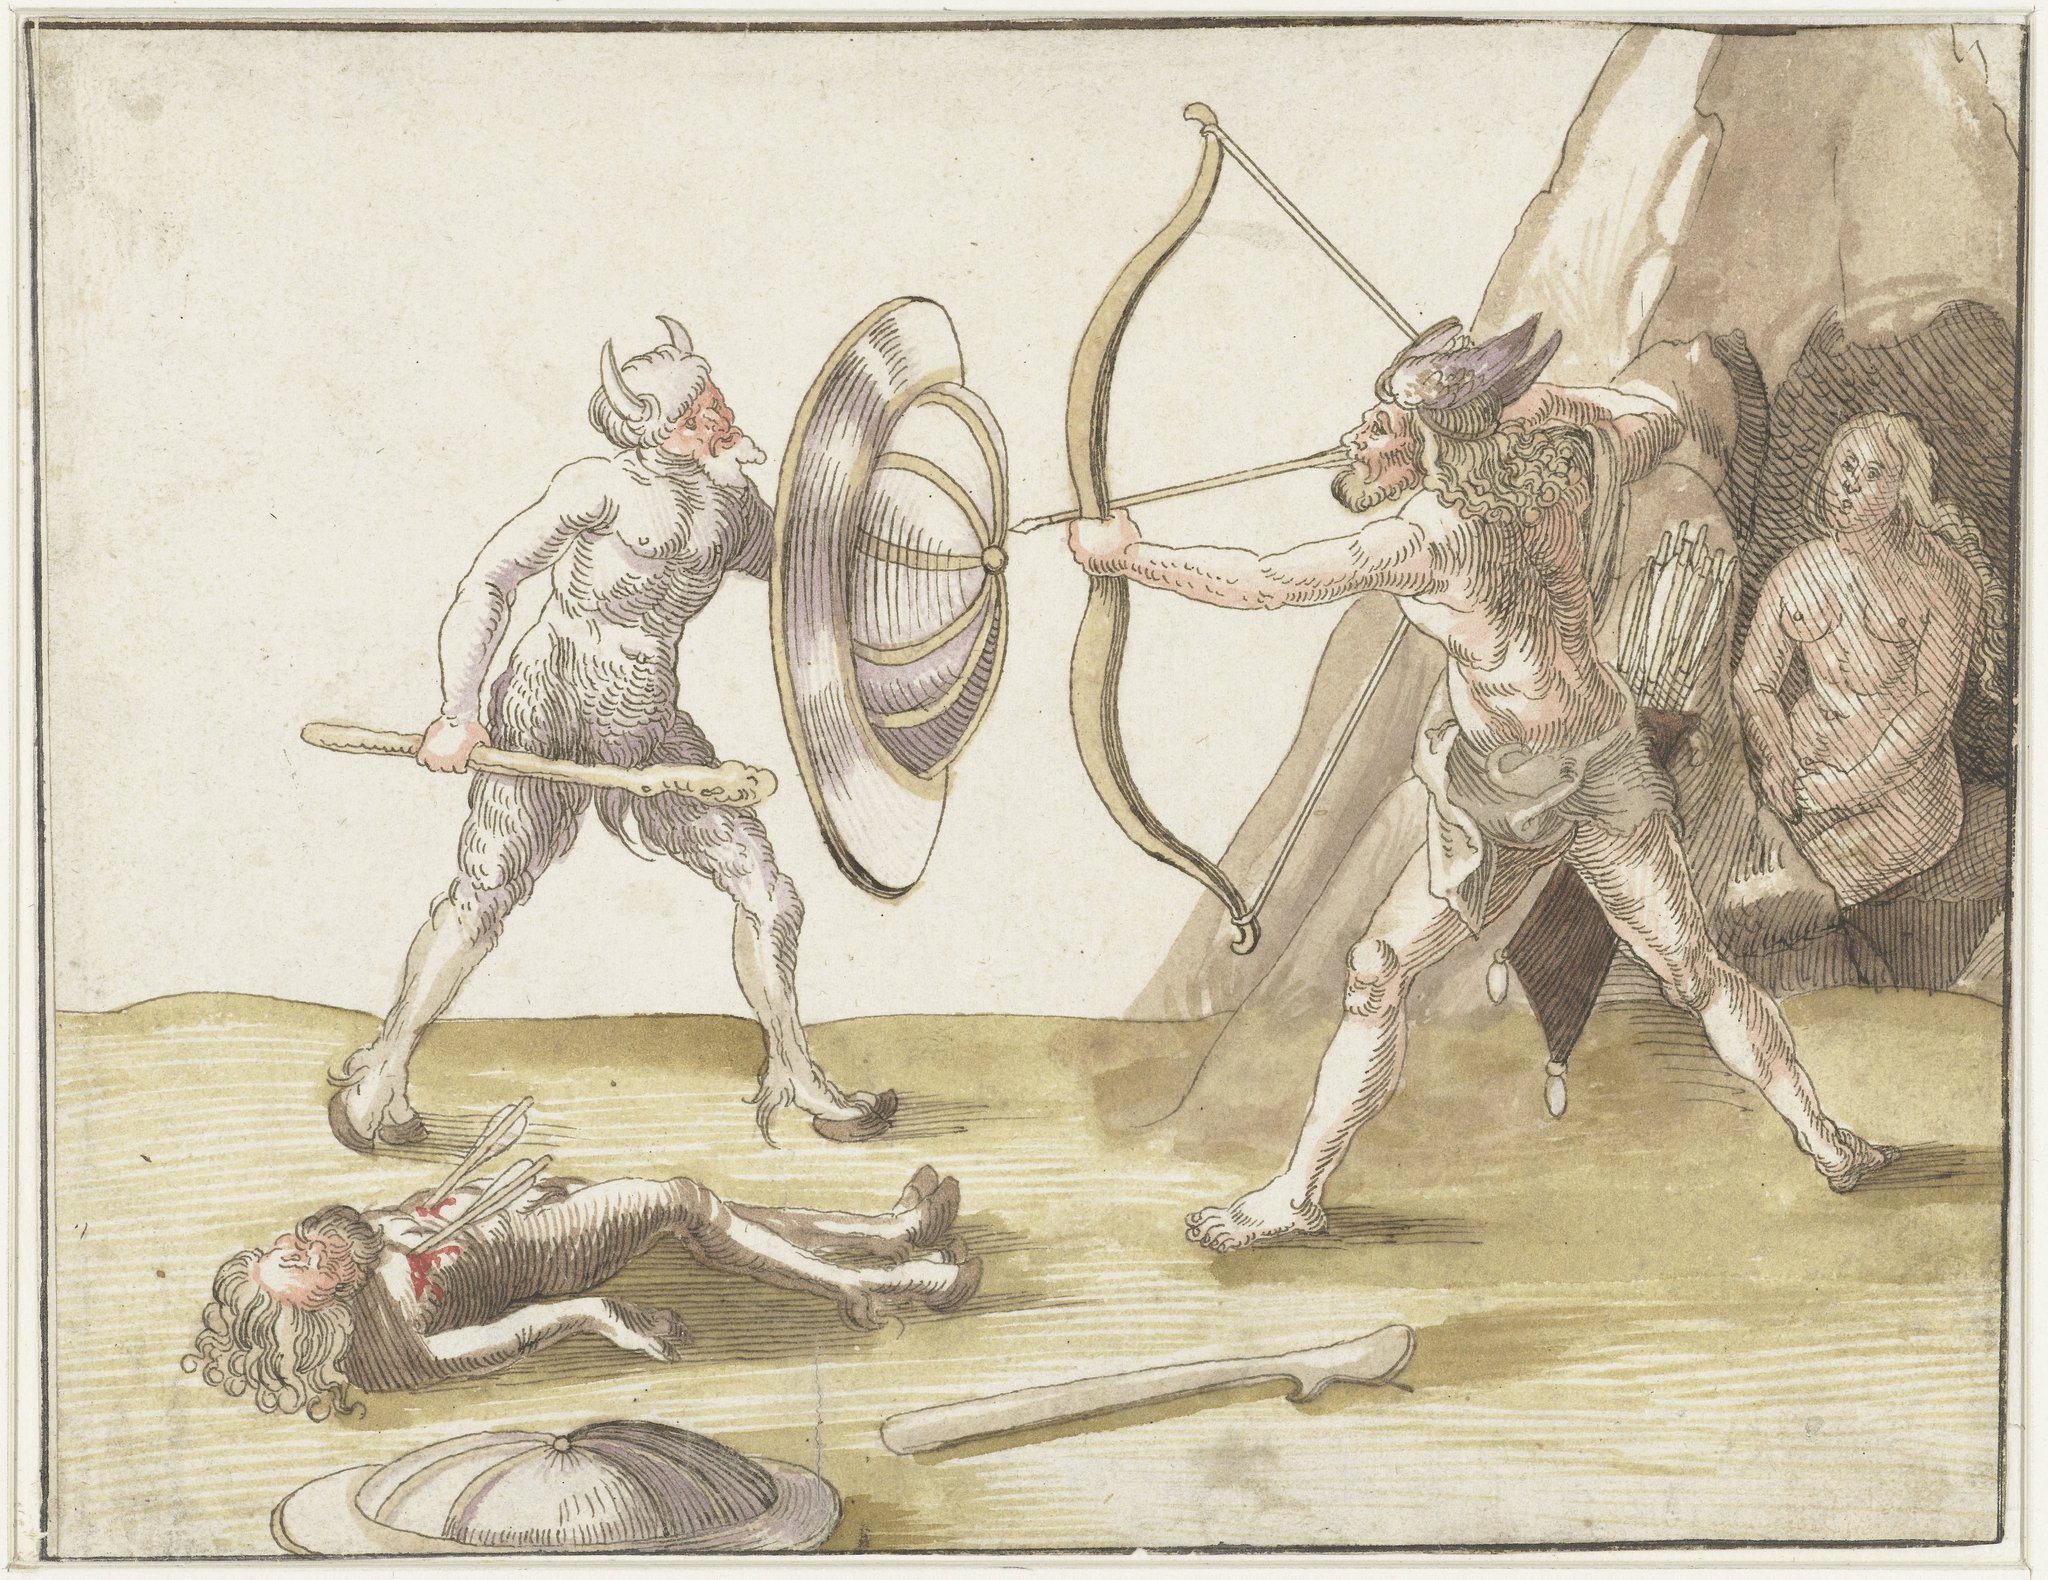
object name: drawing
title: Gevecht tussen twee wildemannen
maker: erhard schön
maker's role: draughtsman, print maker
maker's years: 1491-1542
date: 1500-1600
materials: ink, paper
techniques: brush, pen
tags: wild man, wodewose, woodehouse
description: Gevecht tussen twee wildemannen; een derde ligt dood terneer, een vrouw ziet toe.